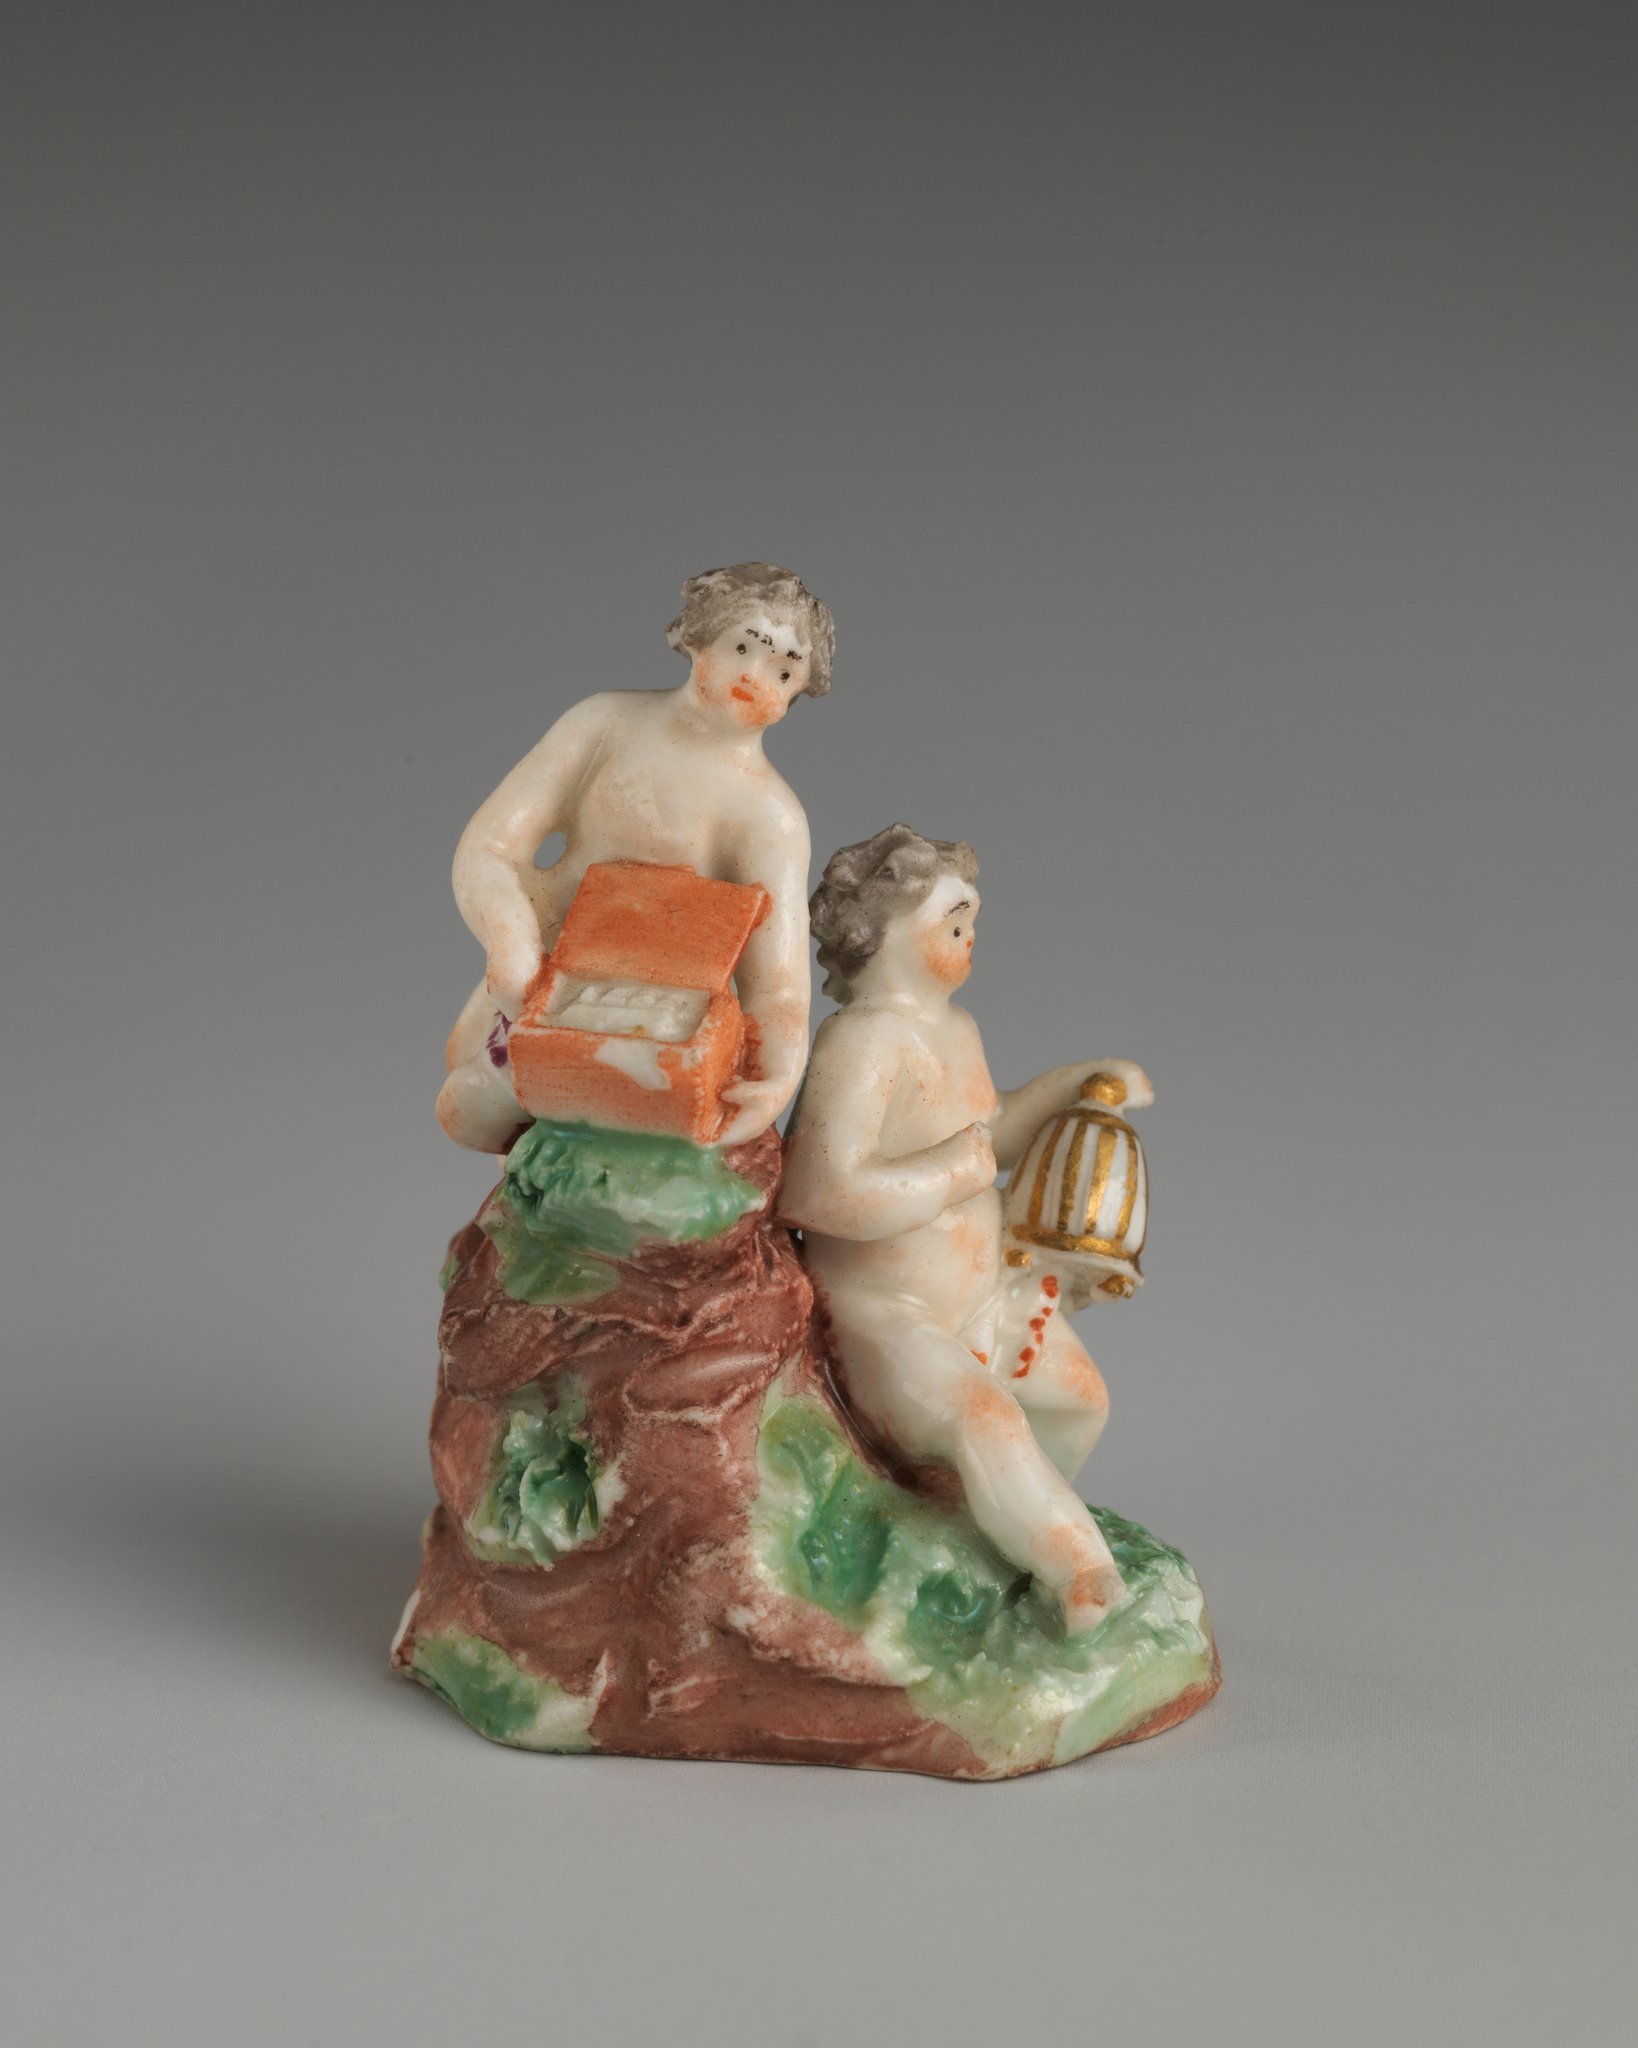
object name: group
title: Two children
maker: chelsea porcelain manufactory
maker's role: factory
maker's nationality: british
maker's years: 1744-1784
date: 1751-1754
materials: soft paste porcelain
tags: children